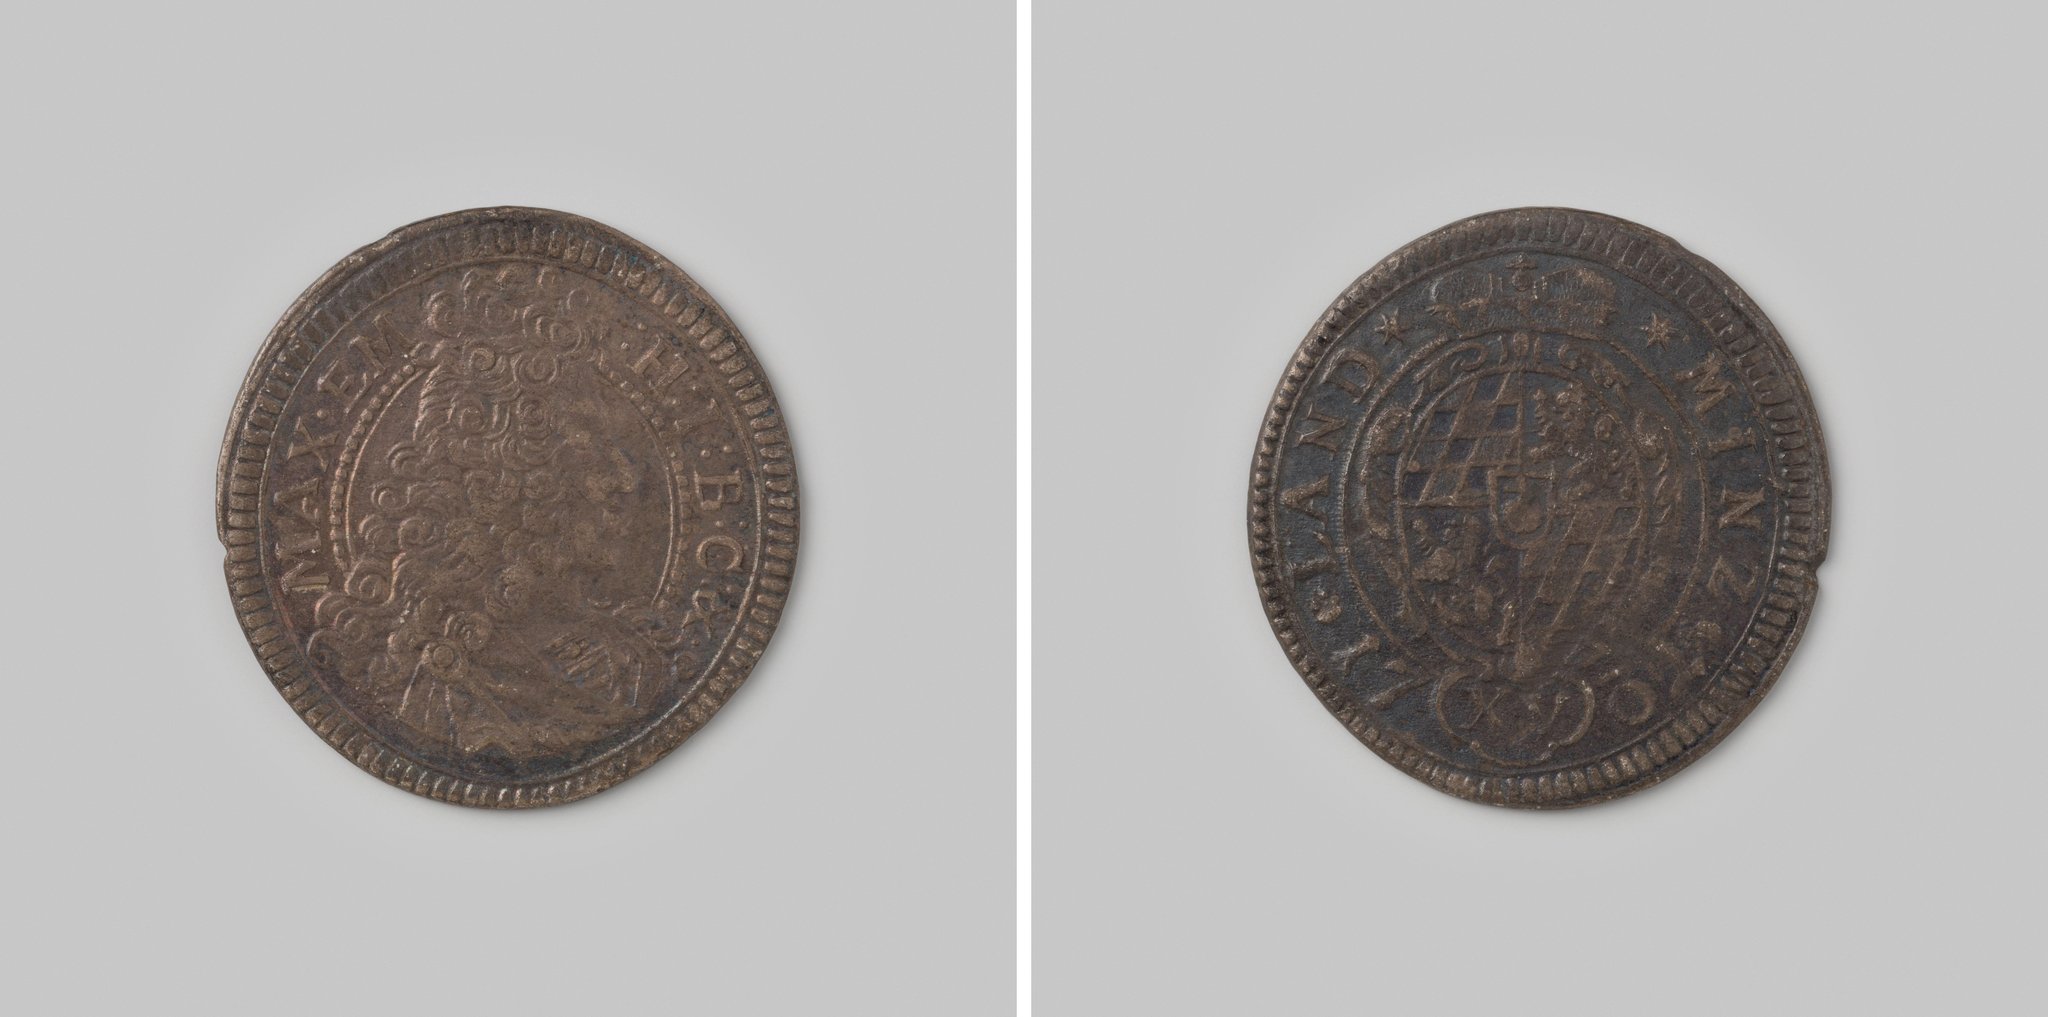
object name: coin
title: 15 Kreuzer uit het hertogdom Beieren van keurvorst Maximilian Emanuel, 1702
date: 1702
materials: silver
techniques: striking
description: Zilveren munt. Voorzijde: borstbeeld van de keurvorst naar rechts. Keerzijde: gekroond versierd wapenschild, waaronder waarde-aanduiding in Romeinse cijfers. Daaromheen jaartal. Gladde rand.